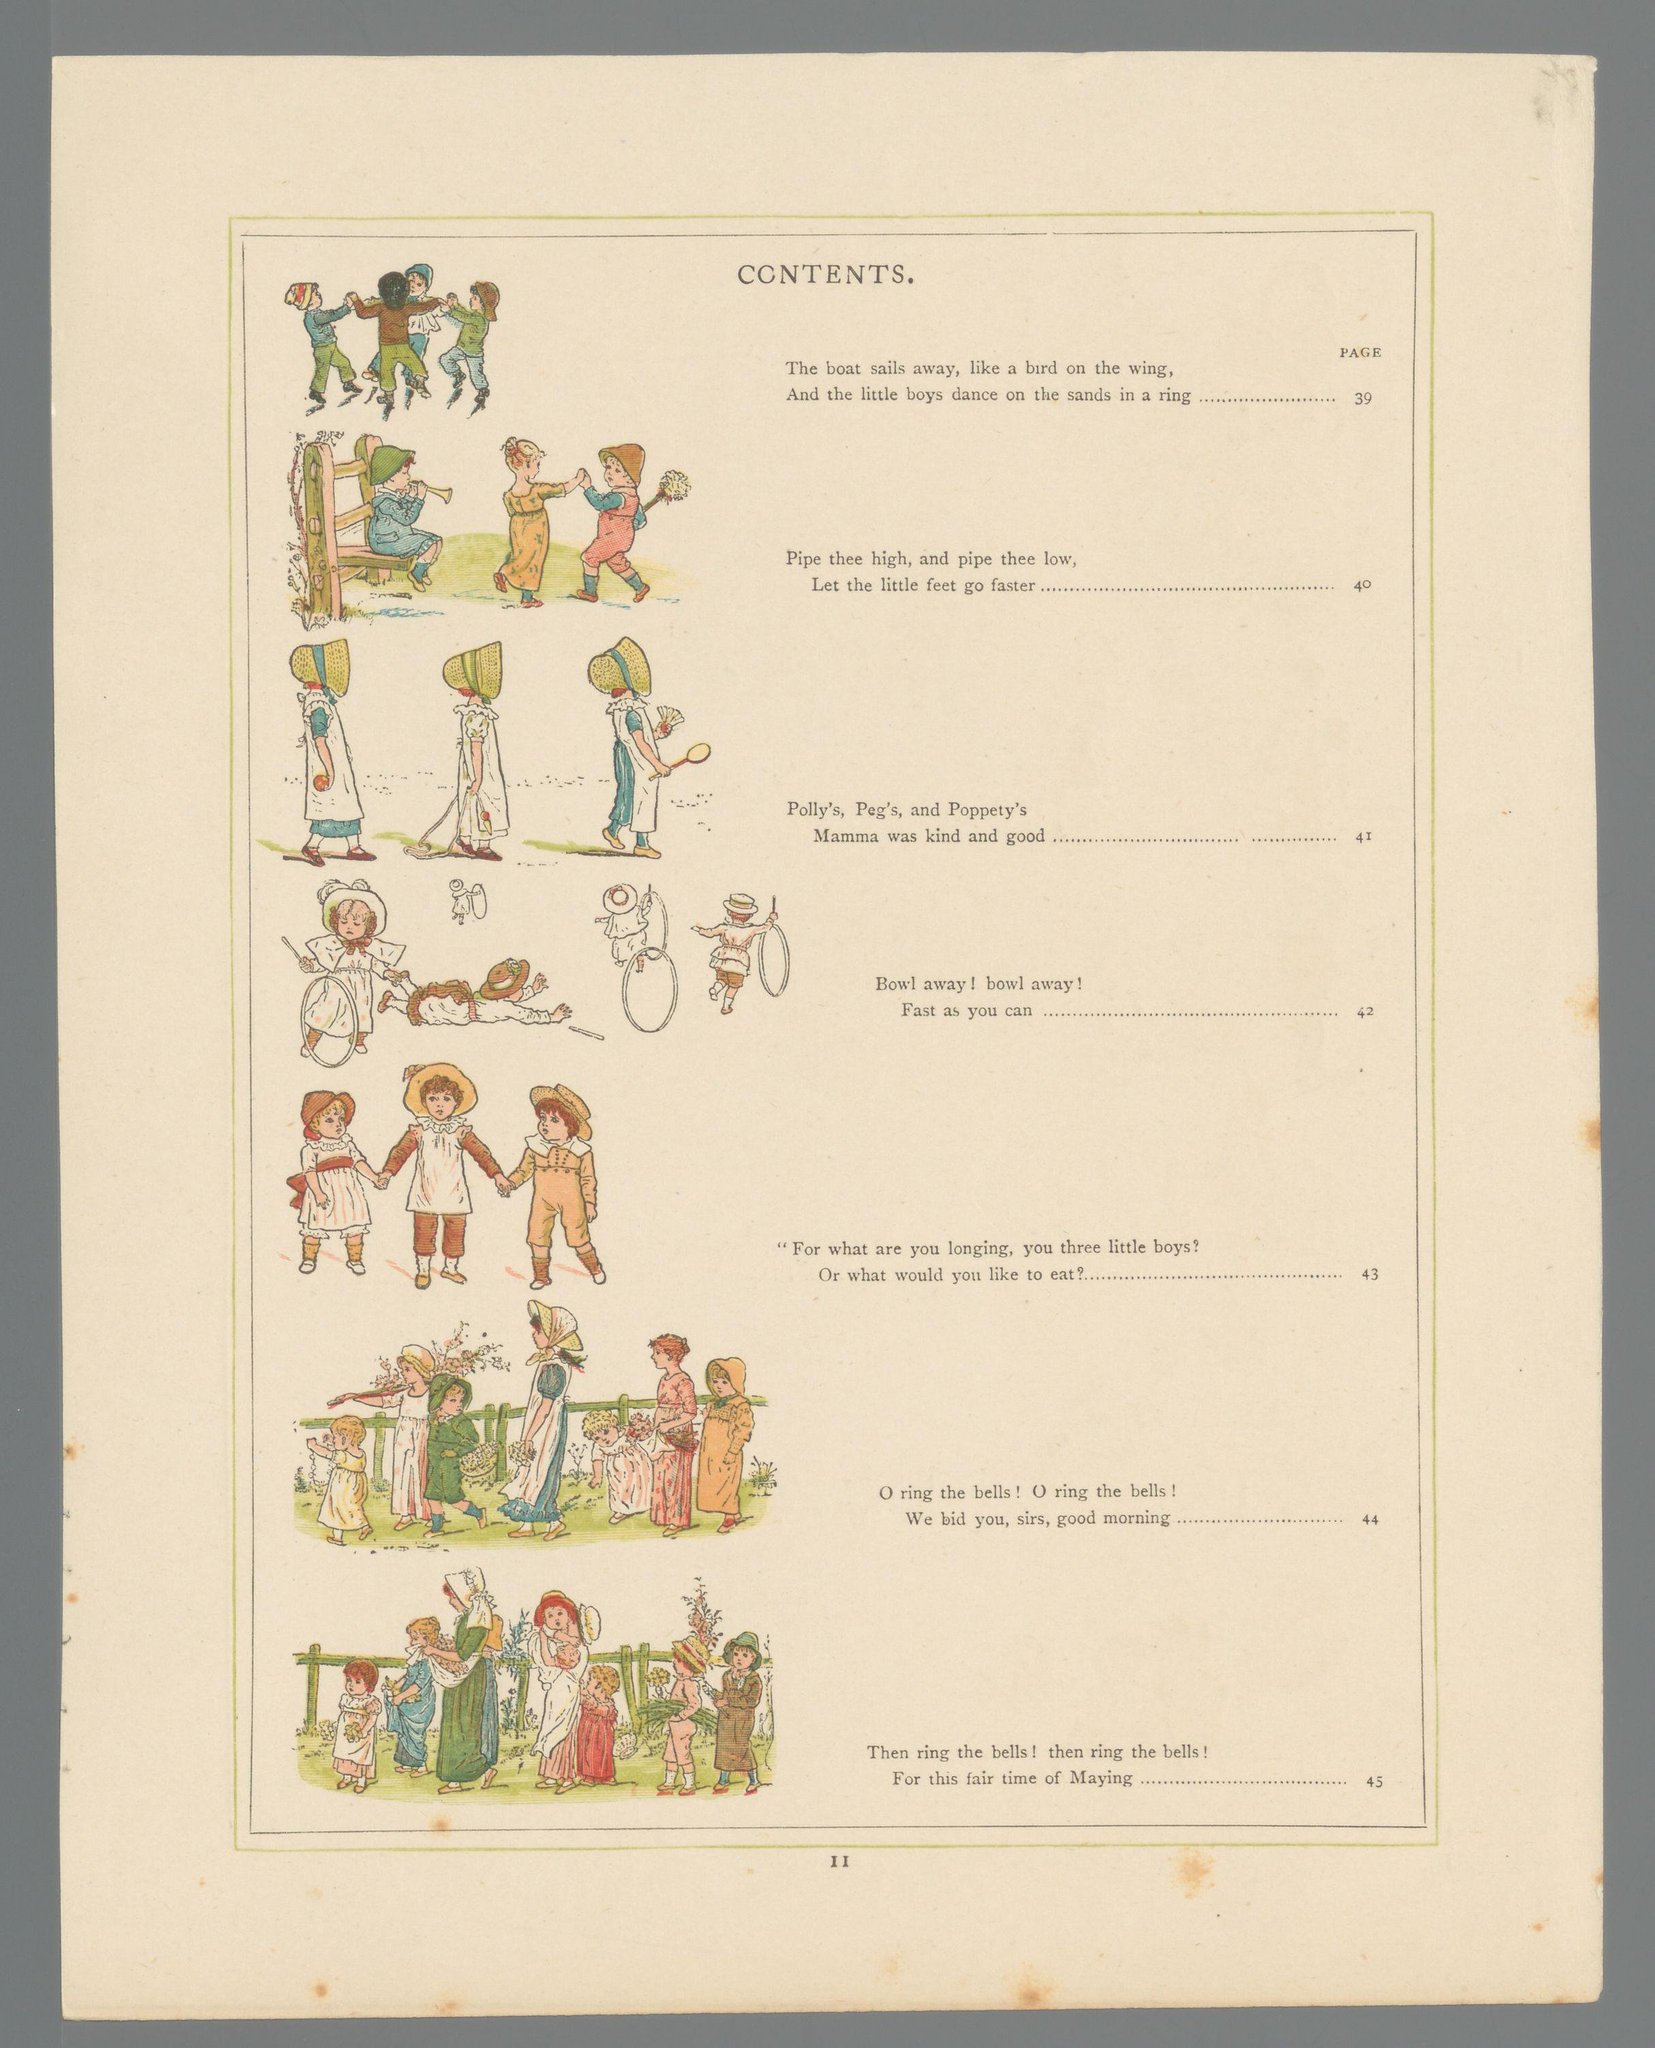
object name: book illustration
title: Zeven voorstellingen met spelende kinderen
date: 1878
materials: paper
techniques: wood engraving, letterpress printing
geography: london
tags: children's games and plays, child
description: Prent uit: Greenaway, Kate. Under the window, pictures & rhymes for children. Londen: George Routledge & Sons, 1878, p. 11.